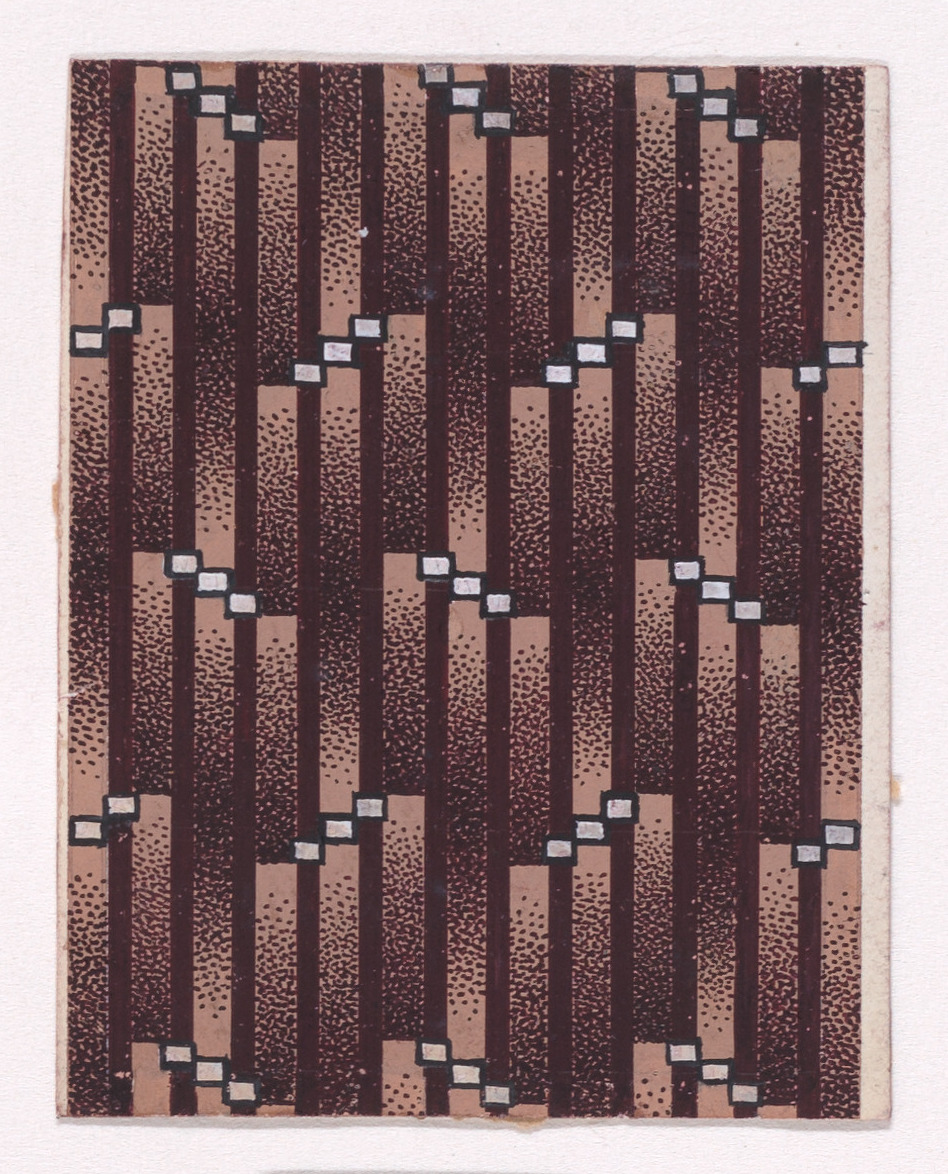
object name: drawing ornament architecture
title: Textile Design with Alternating Diagonal Strings of Squares over a Striped Background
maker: anonymous, alsatian, 19th century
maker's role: artist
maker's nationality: alsatian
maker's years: 1800-1900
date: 1840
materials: gouache